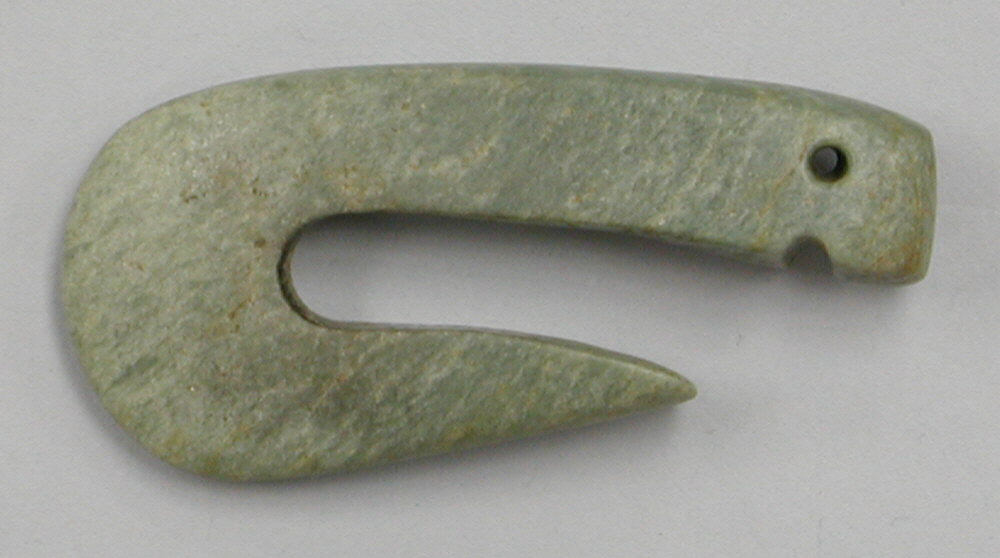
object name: pendant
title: Hook Pendant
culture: mexican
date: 1501-1600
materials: stone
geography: mexico